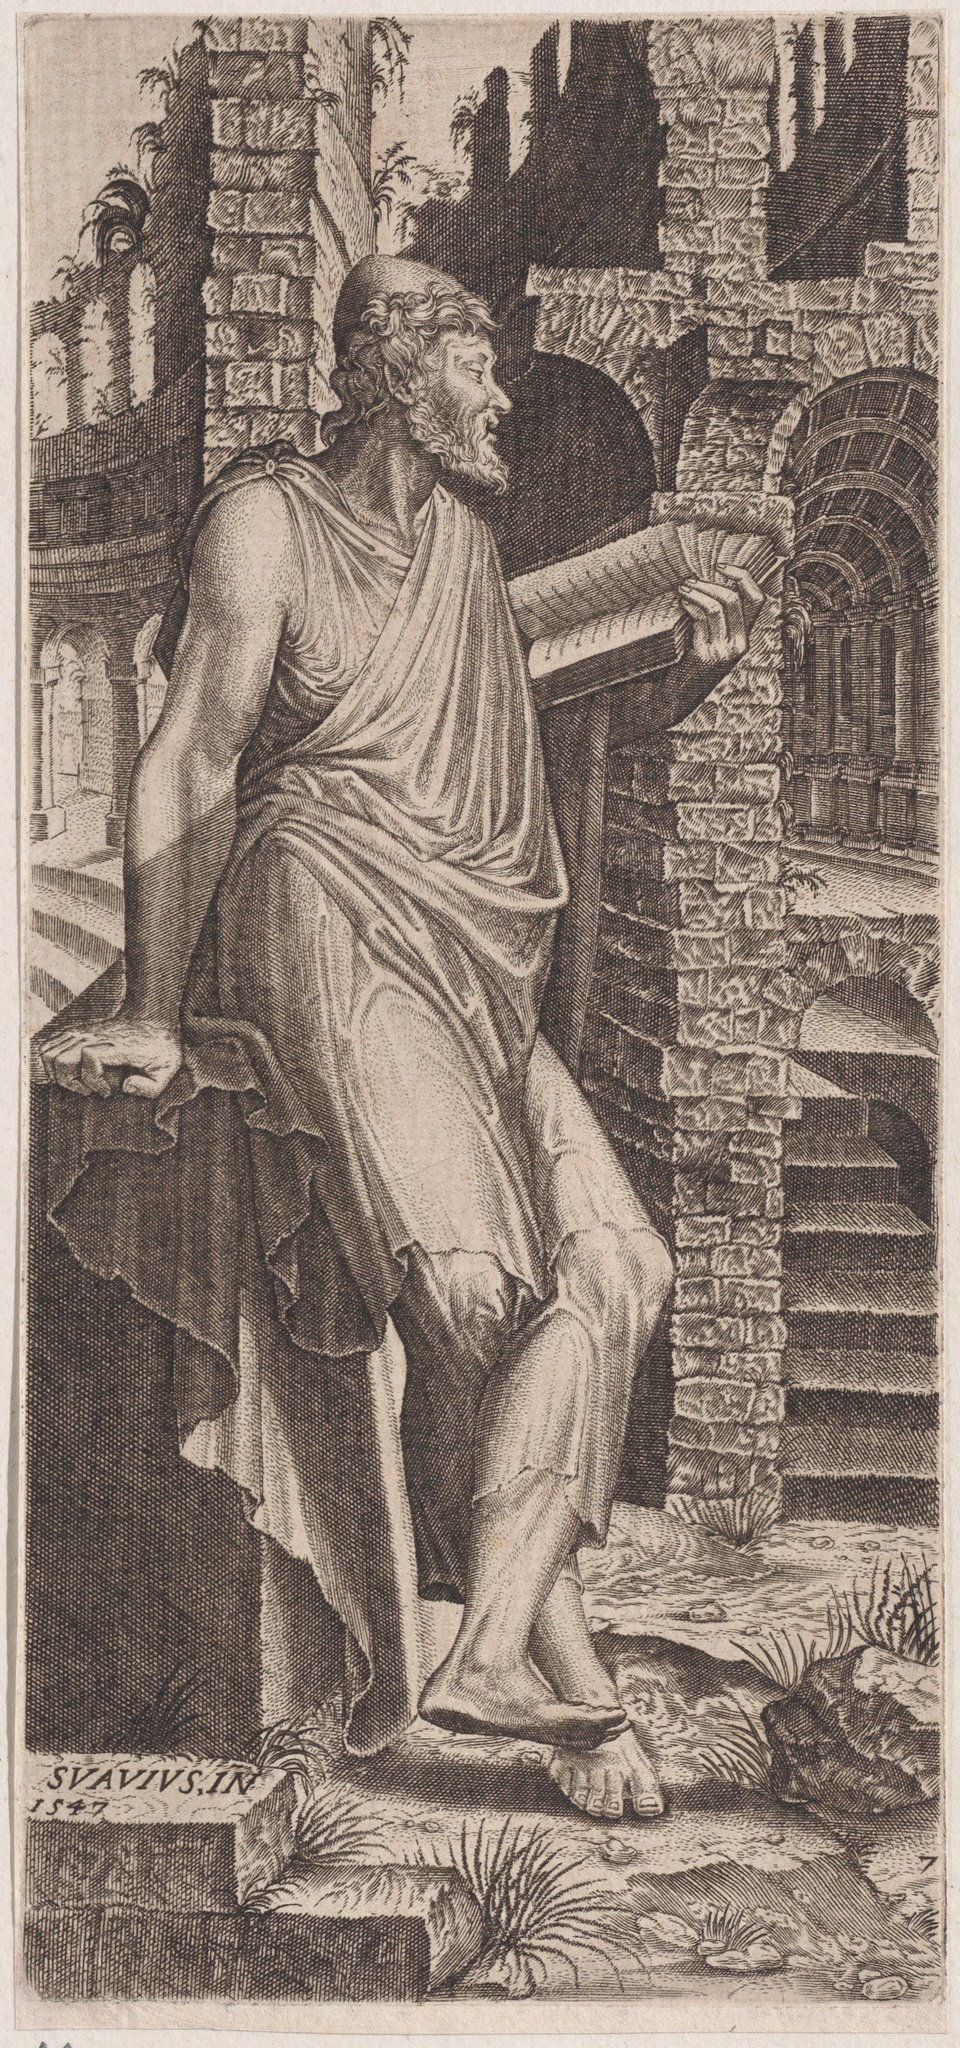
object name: print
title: St. Matthew, from "Christ, the Twelve Apostles and St. Paul"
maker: lambert suavius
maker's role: artist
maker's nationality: netherlandish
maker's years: 1510-1576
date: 1525-1576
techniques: engraving